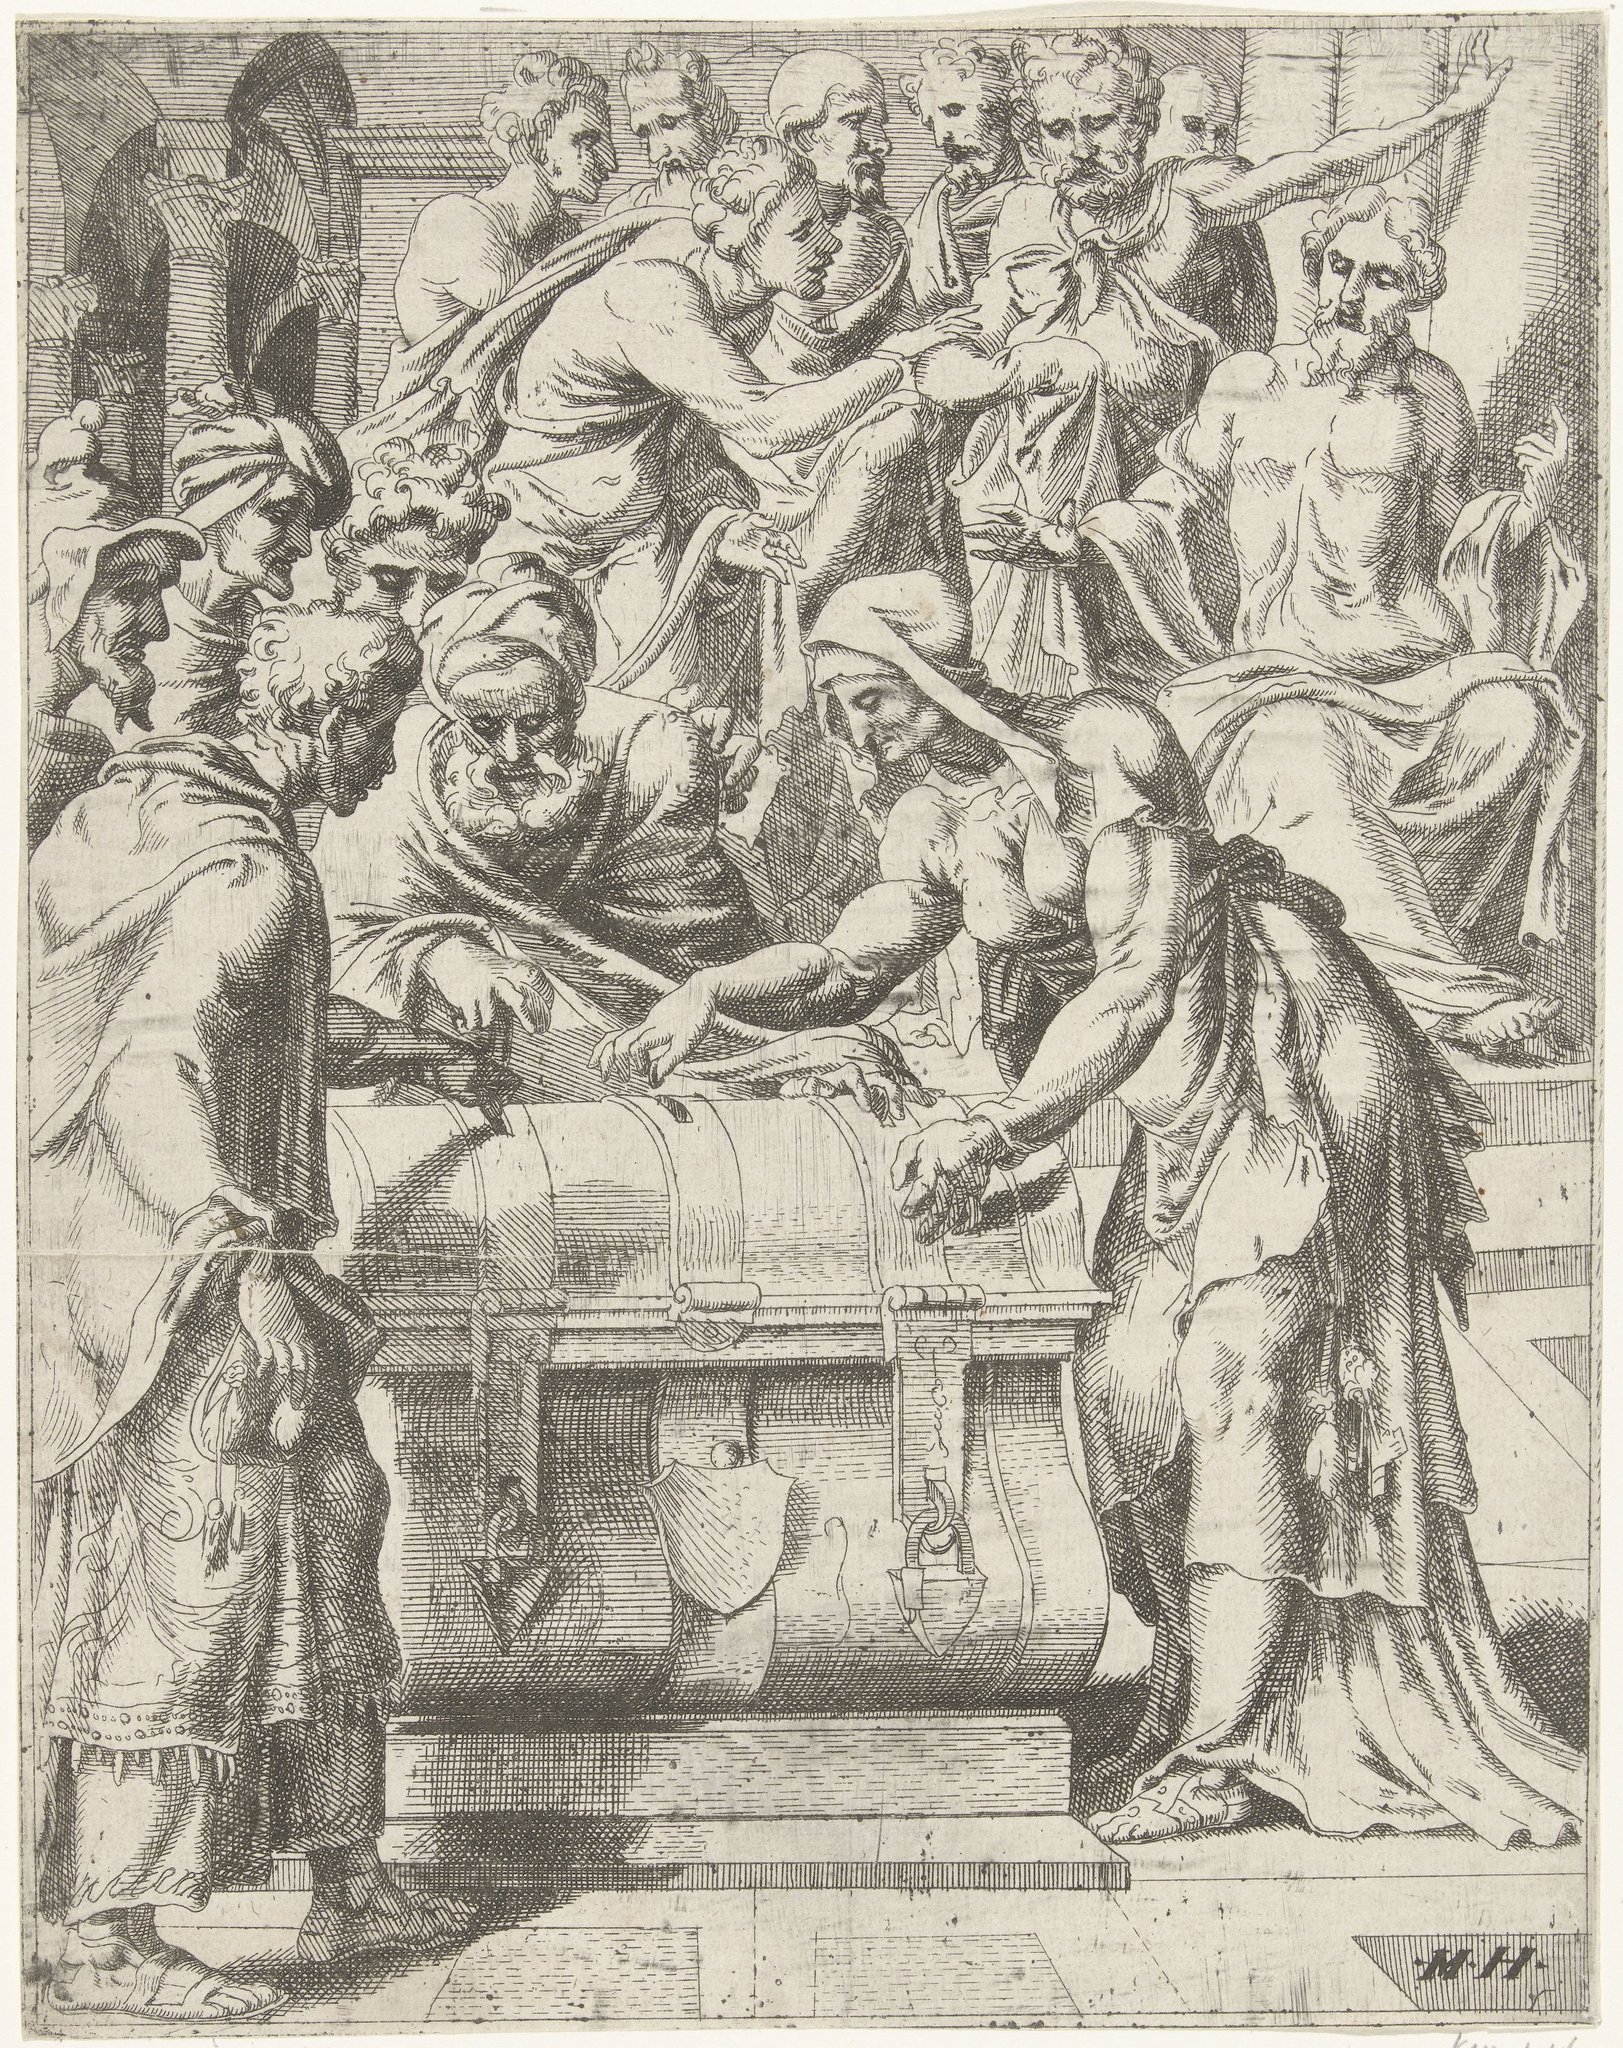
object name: print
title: Vrijgevigheid van de arme weduwe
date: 1548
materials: paper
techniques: etching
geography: haarlem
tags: the widow's mite: christ draws the disciples' attention to a woman who puts a few coins in the temple's money chest (mark 12:41-44; luke 21:1-4)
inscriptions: collector's mark: Lugt 2228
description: Christus wijst zijn leerlingen op een arme weduwe die wat geld in de offerkist werpt. Deze weduwe heeft meer gegeven dan de grote giften van de rijken, omdat zij dat geld niet kan missen. De prent is deel van een dertigdelige serie met prenten over de zondeval en Christus' passie.